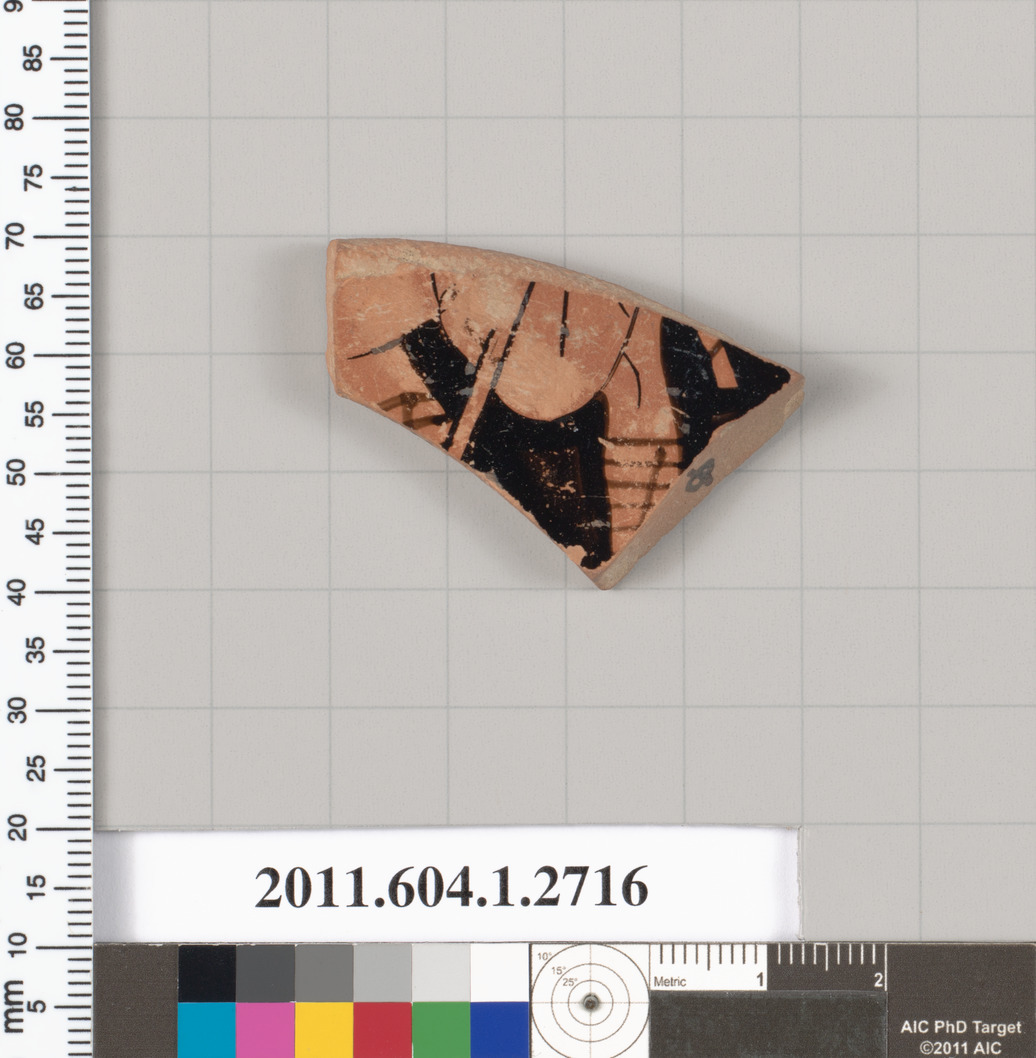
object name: kylix fragment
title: Terracotta fragment of a kylix (drinking cup)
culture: greek, attic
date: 460-450 BCE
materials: terracotta